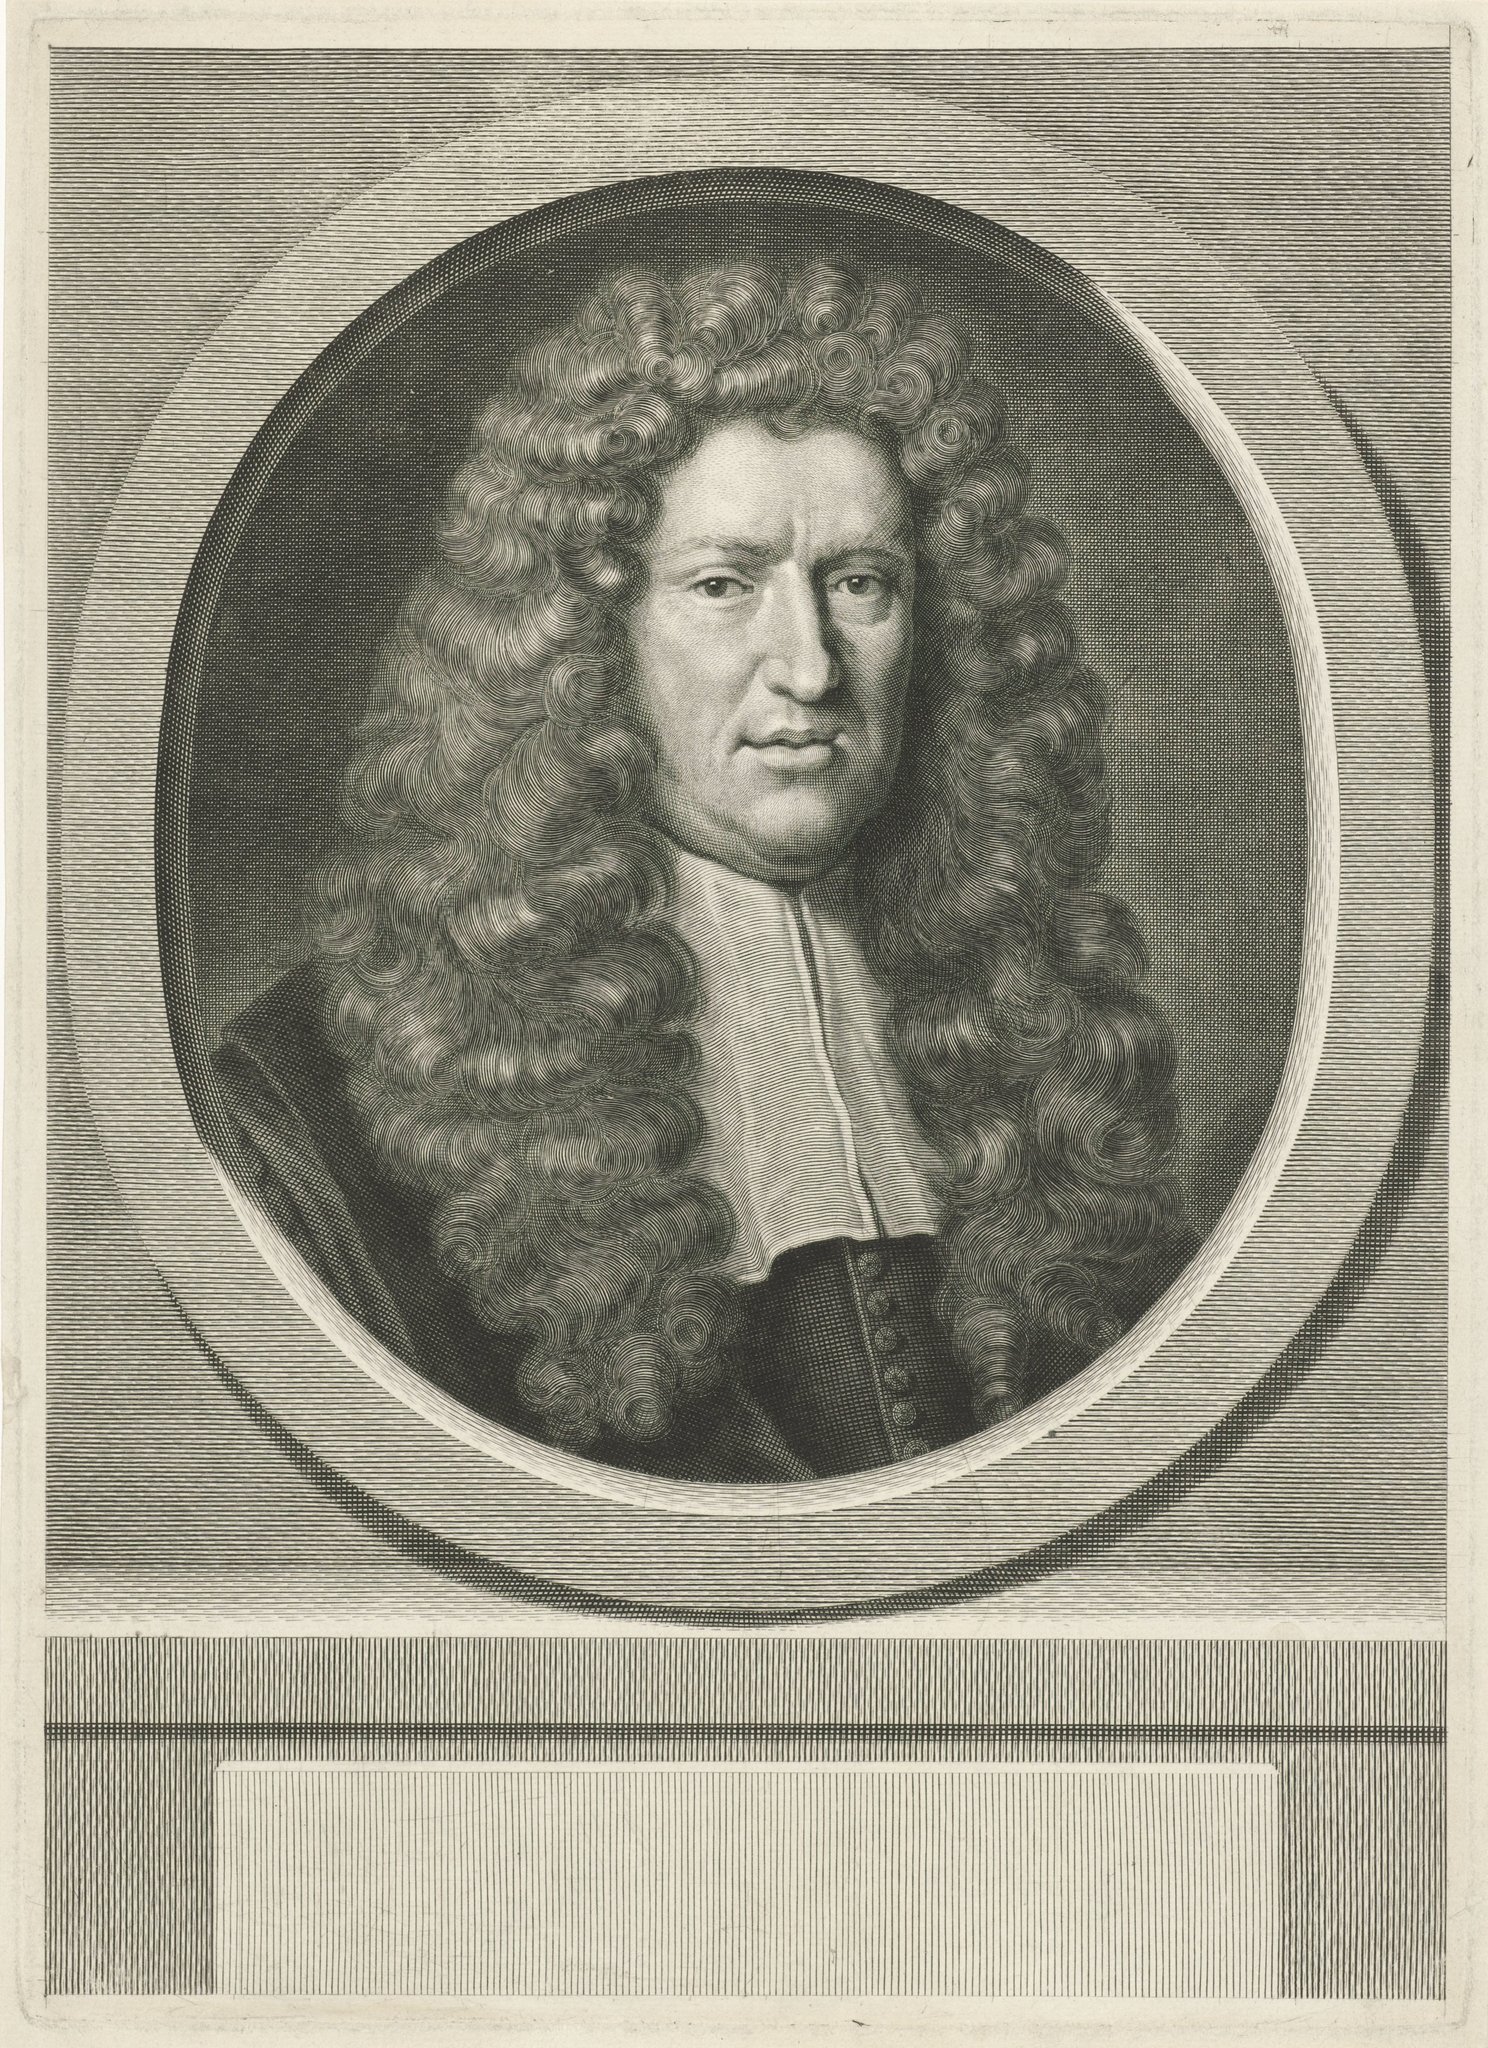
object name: print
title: Portret van Karel Rudolph van Kuffeler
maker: jan van munnickhuysen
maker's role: draughtsman, print maker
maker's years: 1655-1701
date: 1685-1702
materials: paper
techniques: engraving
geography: netherlands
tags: amsterdam, politician, historical persons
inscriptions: collector's mark: Lugt 2228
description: Portret van Karel Rudolph van Kuffeler met witte bef.